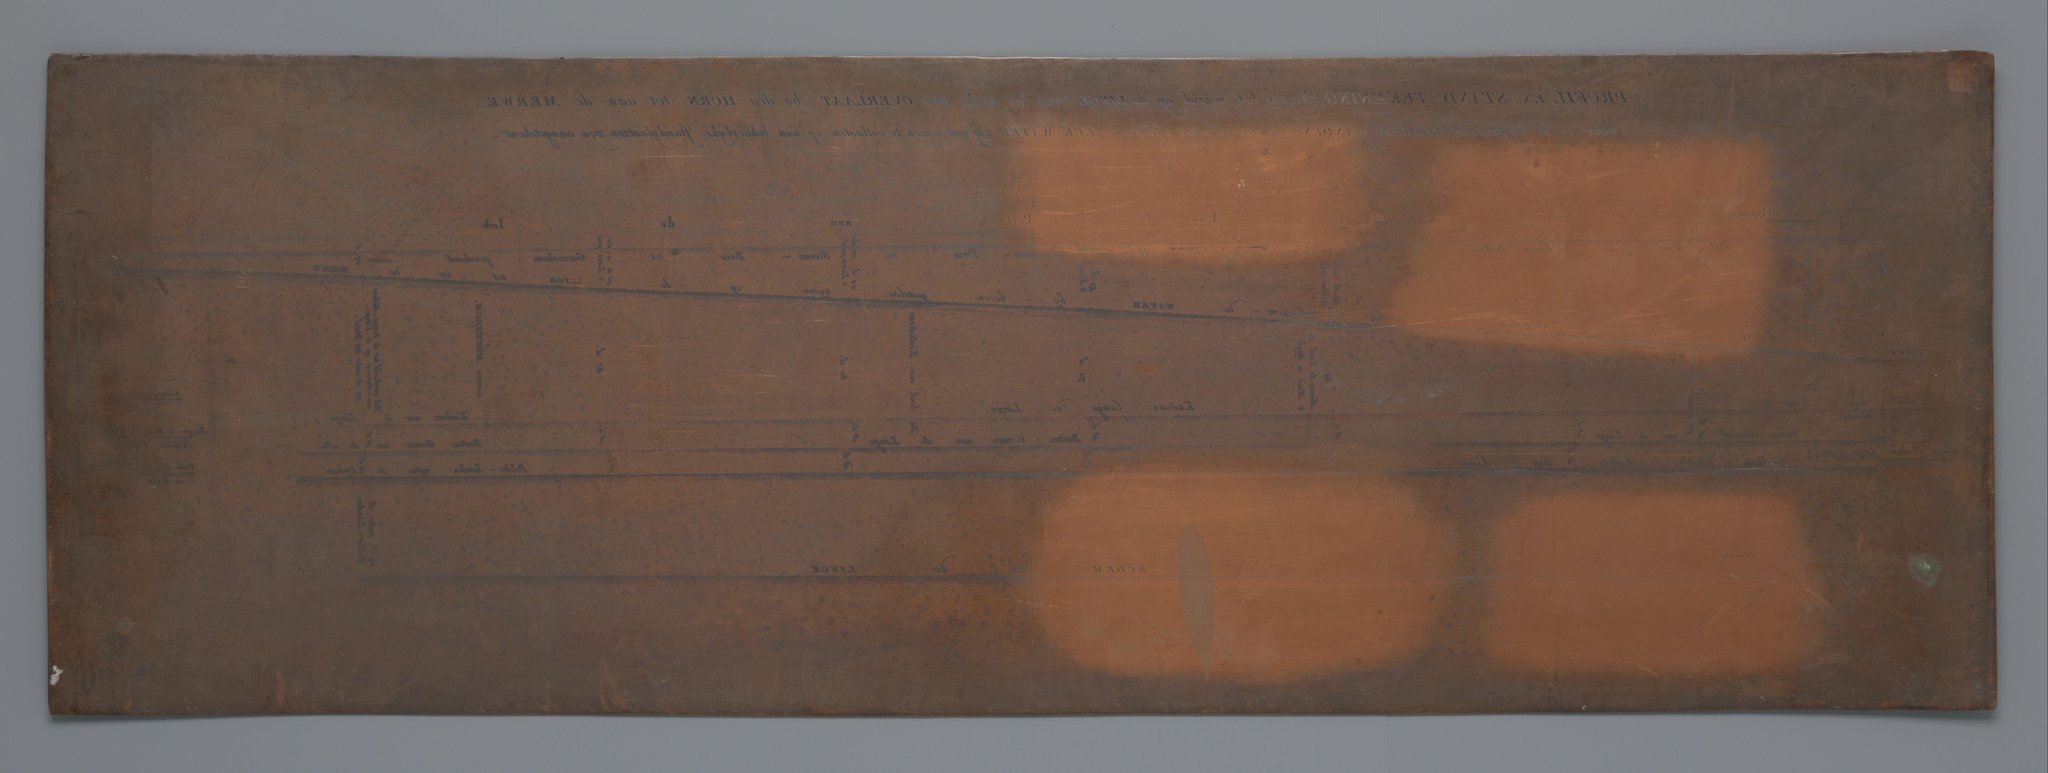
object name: copper plate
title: Koperplaat met het profiel van de rivier de Linge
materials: copper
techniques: engraving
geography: the hague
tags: linge